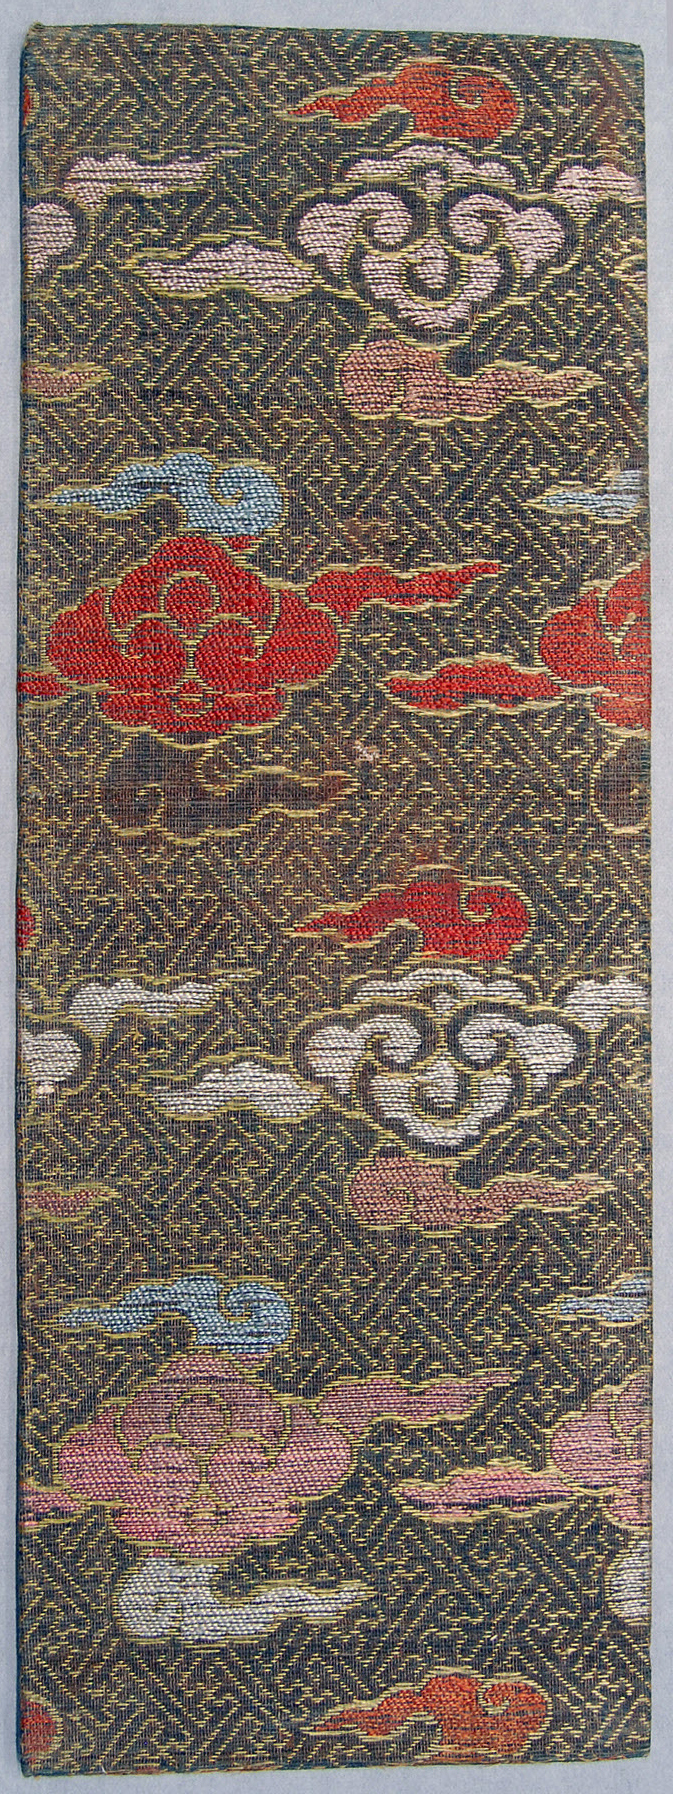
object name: sutra cover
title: Sutra Cover with Multicolored Clouds on an Overall Fretwork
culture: chinese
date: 1501-1600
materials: silk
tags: clouds